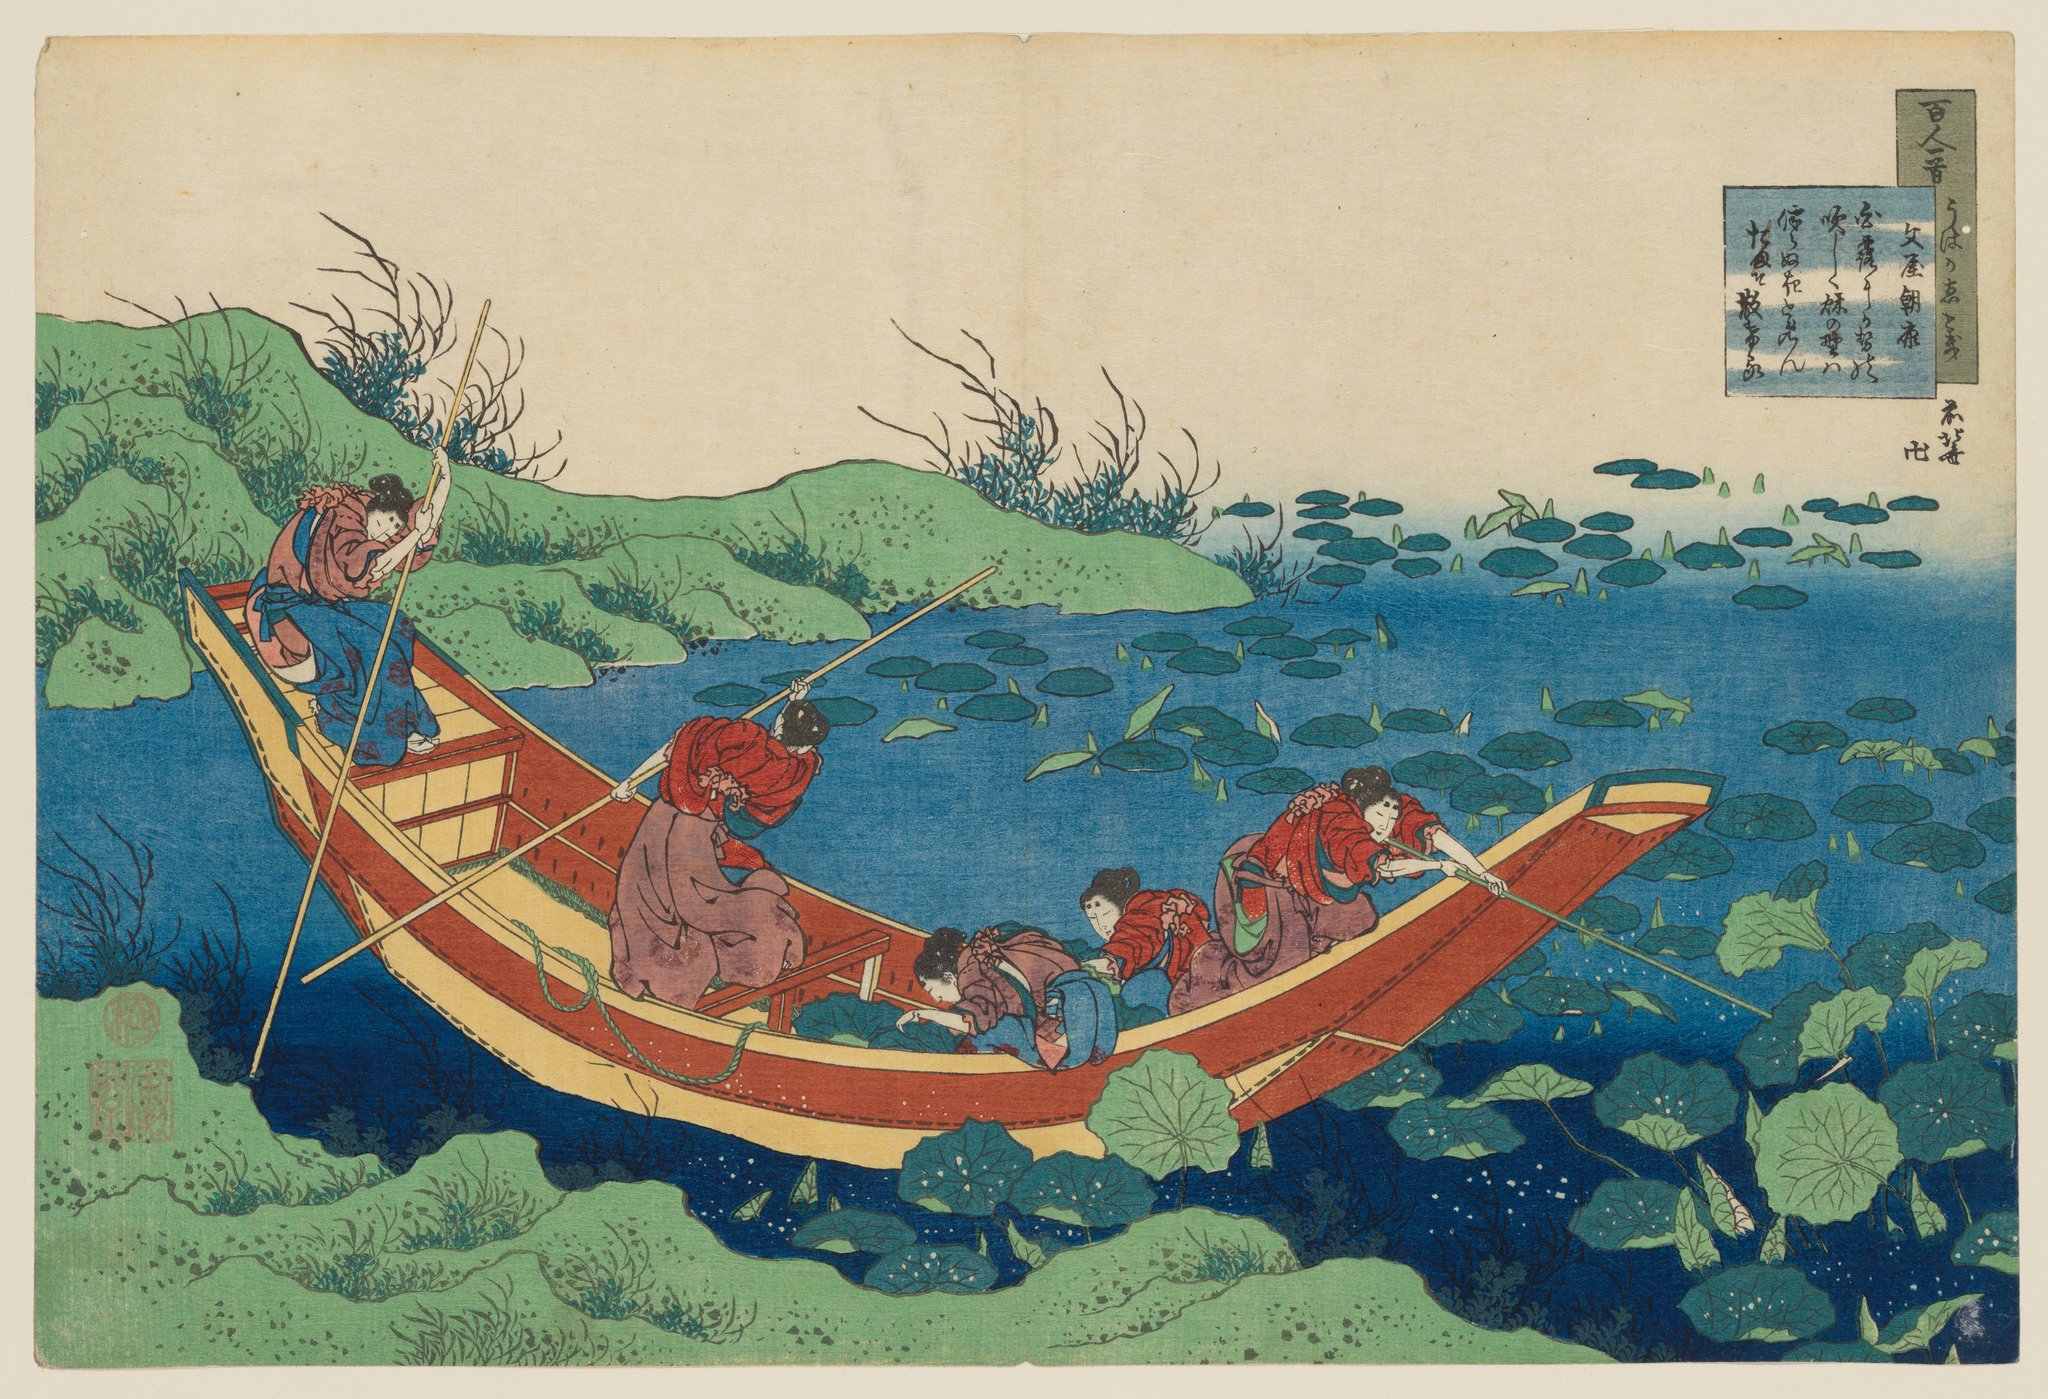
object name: woodblock print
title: Poem by Funya no Asayasu, from the series One Hundred Poems Explained by a Nurse (Hyakunin isshu ubaga etoki)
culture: japanese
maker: katsushika hokusai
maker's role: artist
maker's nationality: japanese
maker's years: 1760-1849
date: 1760-1849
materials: ink, paper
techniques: woodblock print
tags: women,boats